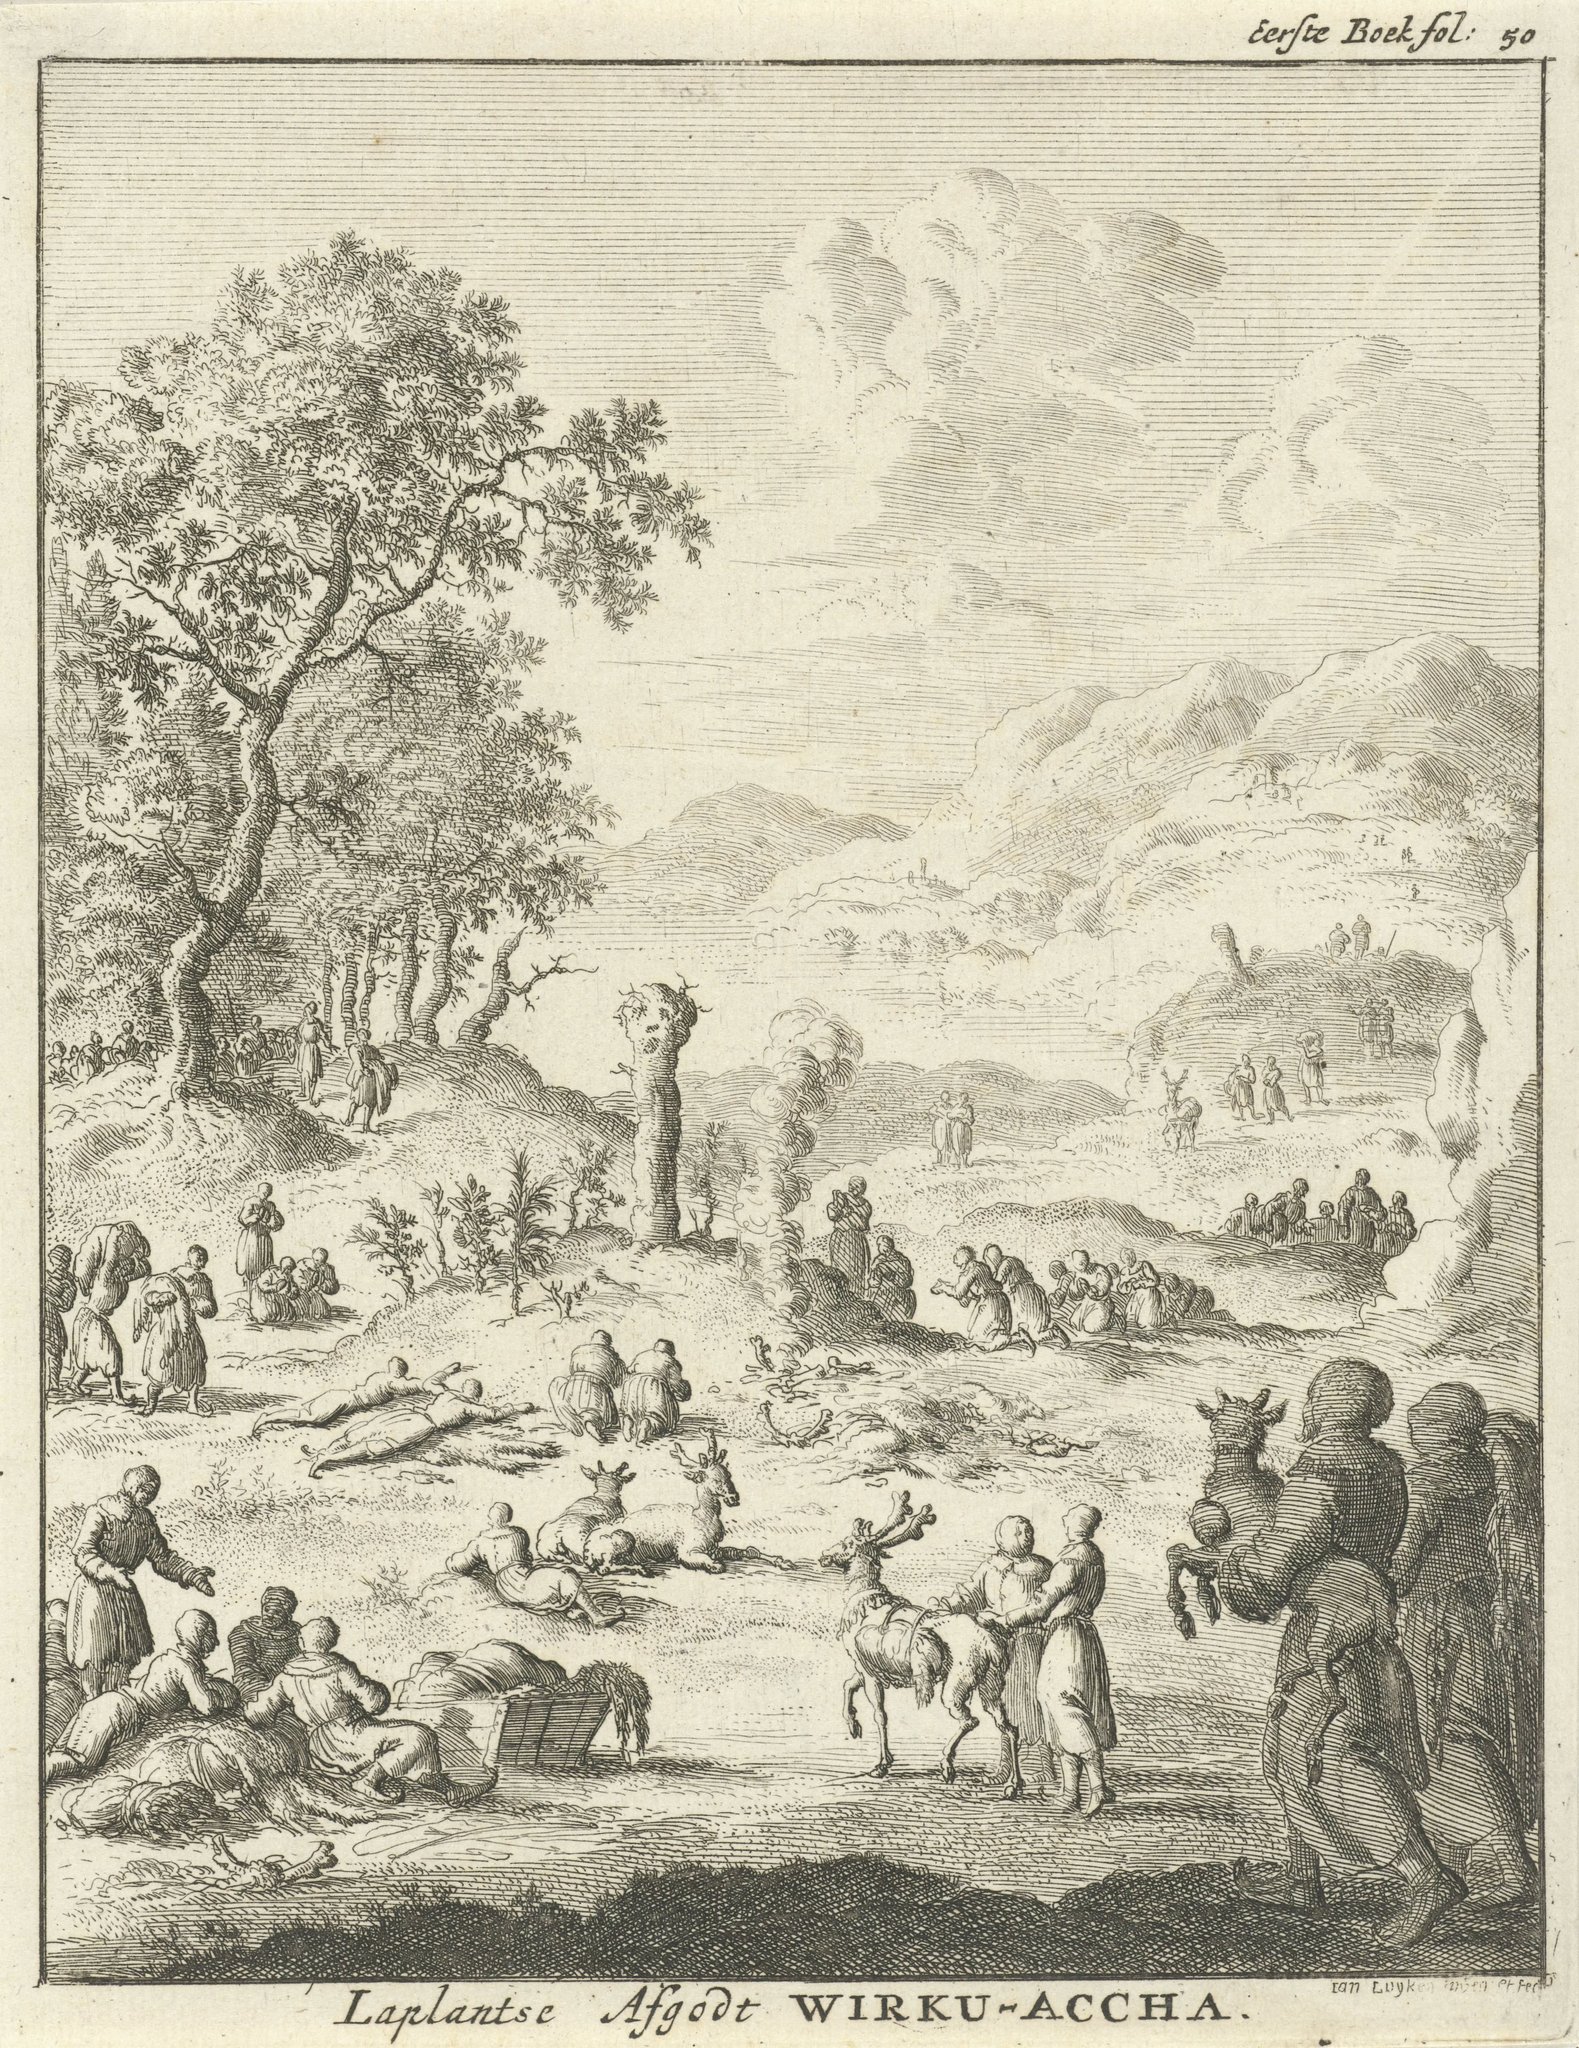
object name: book illustration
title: Sami vereren de god Wirku Accha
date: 1682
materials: paper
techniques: etching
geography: amsterdam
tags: europeans: sami, worship and devotion ~ non-christian religions, sápmi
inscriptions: collector's mark: Lugt 2228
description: Illustratie opgenomen in: Scheffer, Johannes. Waarachtige en aen-merkens-waardige historie van Lapland. Amsterdam: Jan Claesz ten Hoorn, 1682.